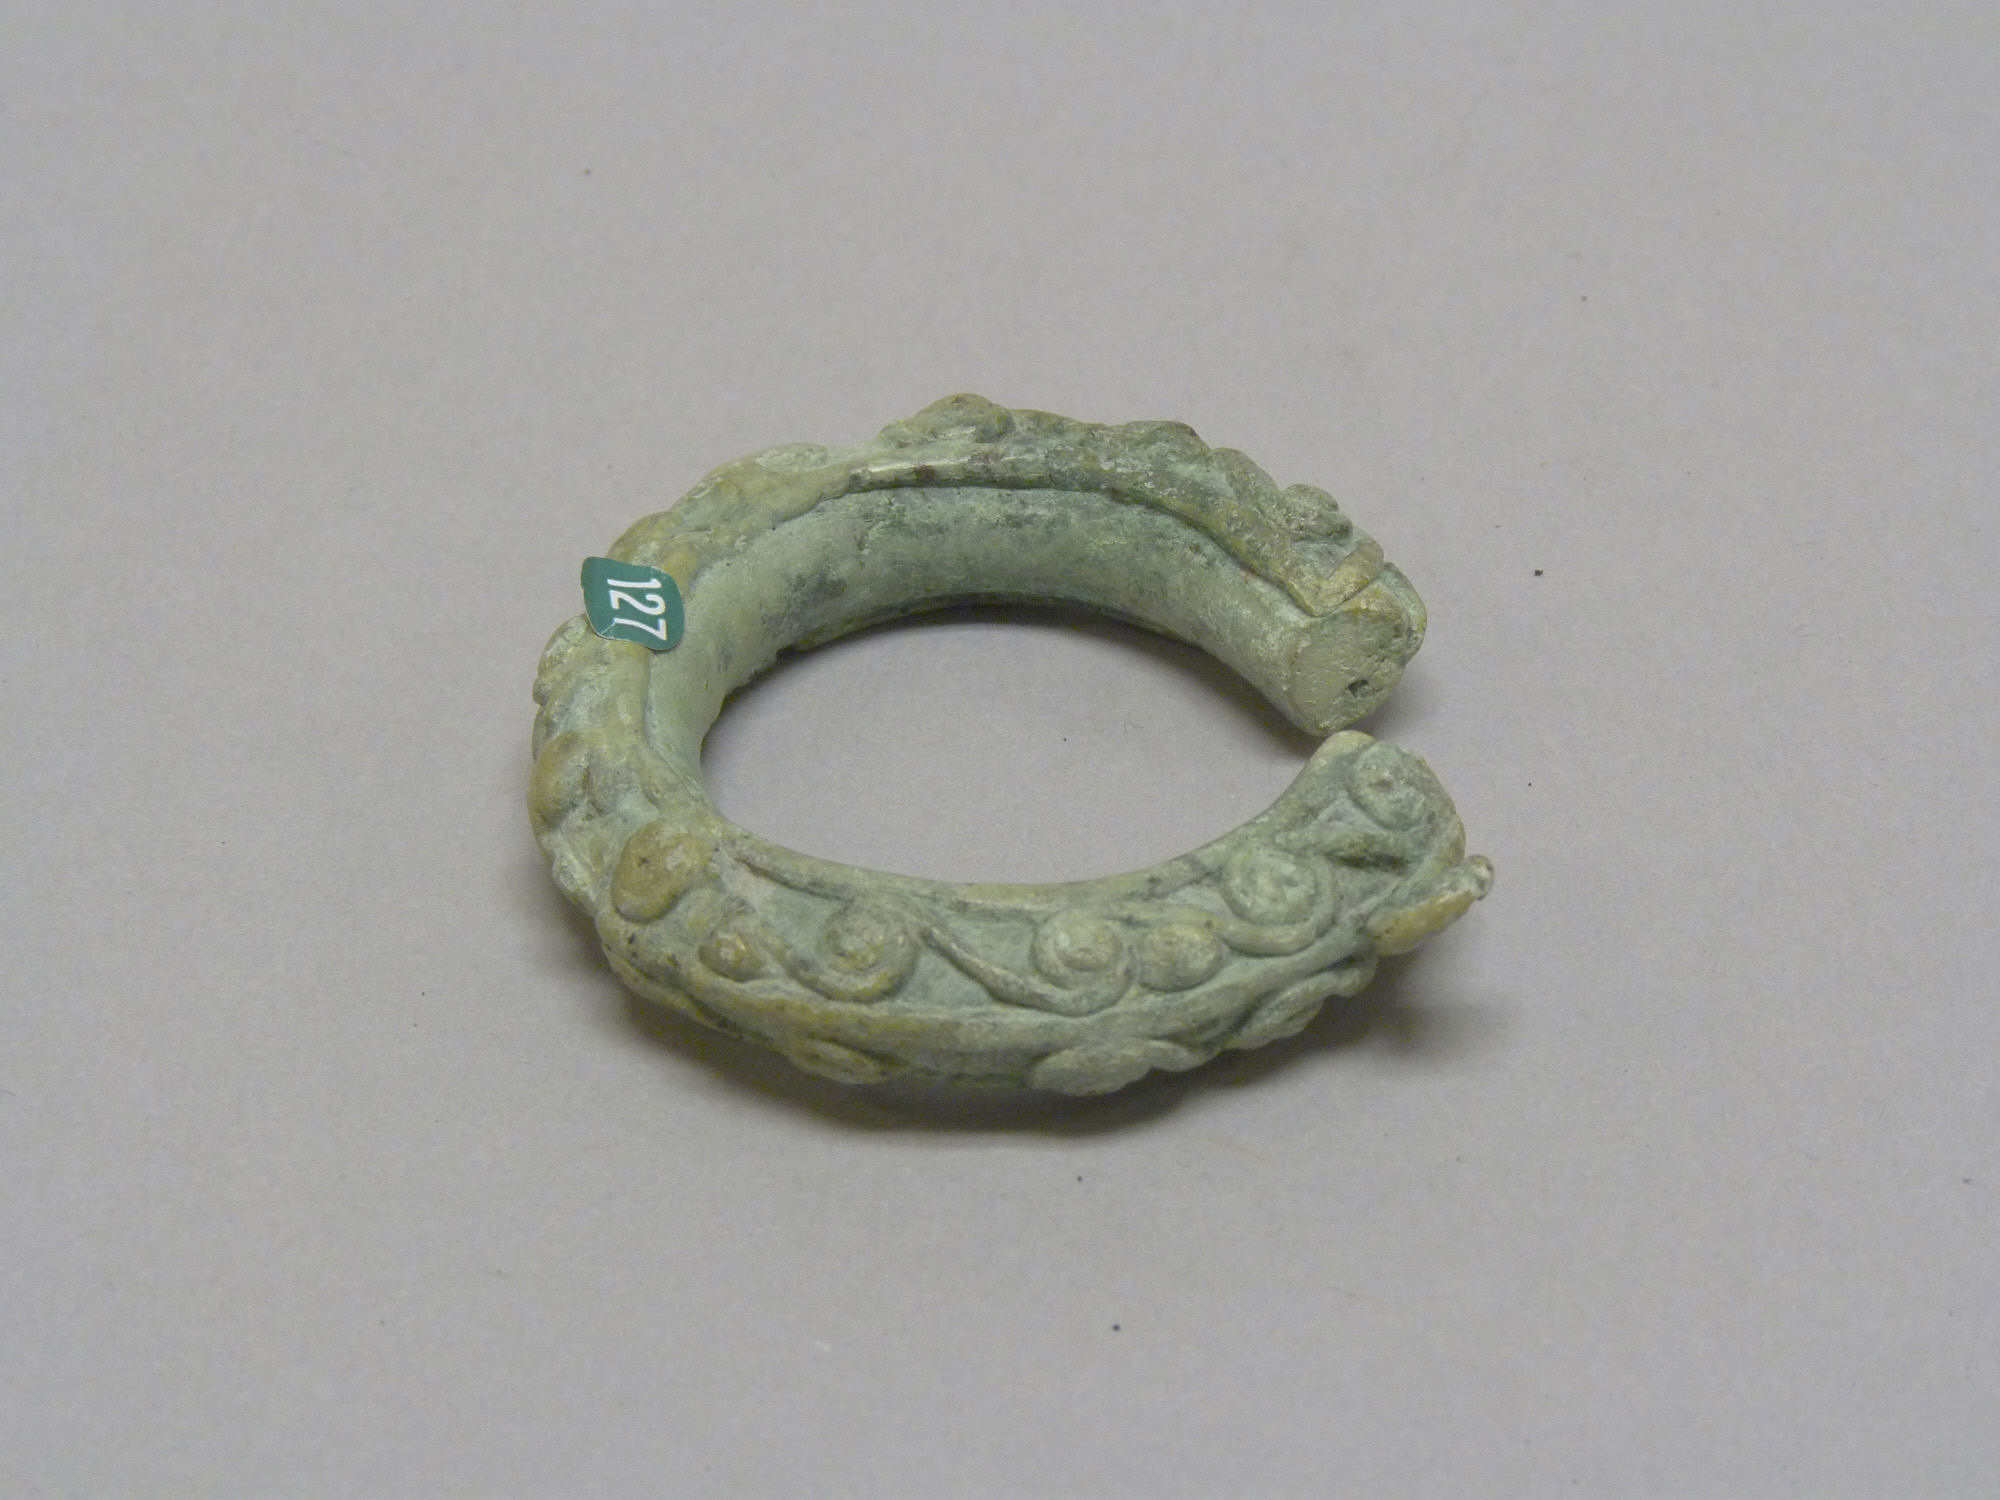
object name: bangle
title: Solid Open Bangle with Applied Decoration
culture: thai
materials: bronze